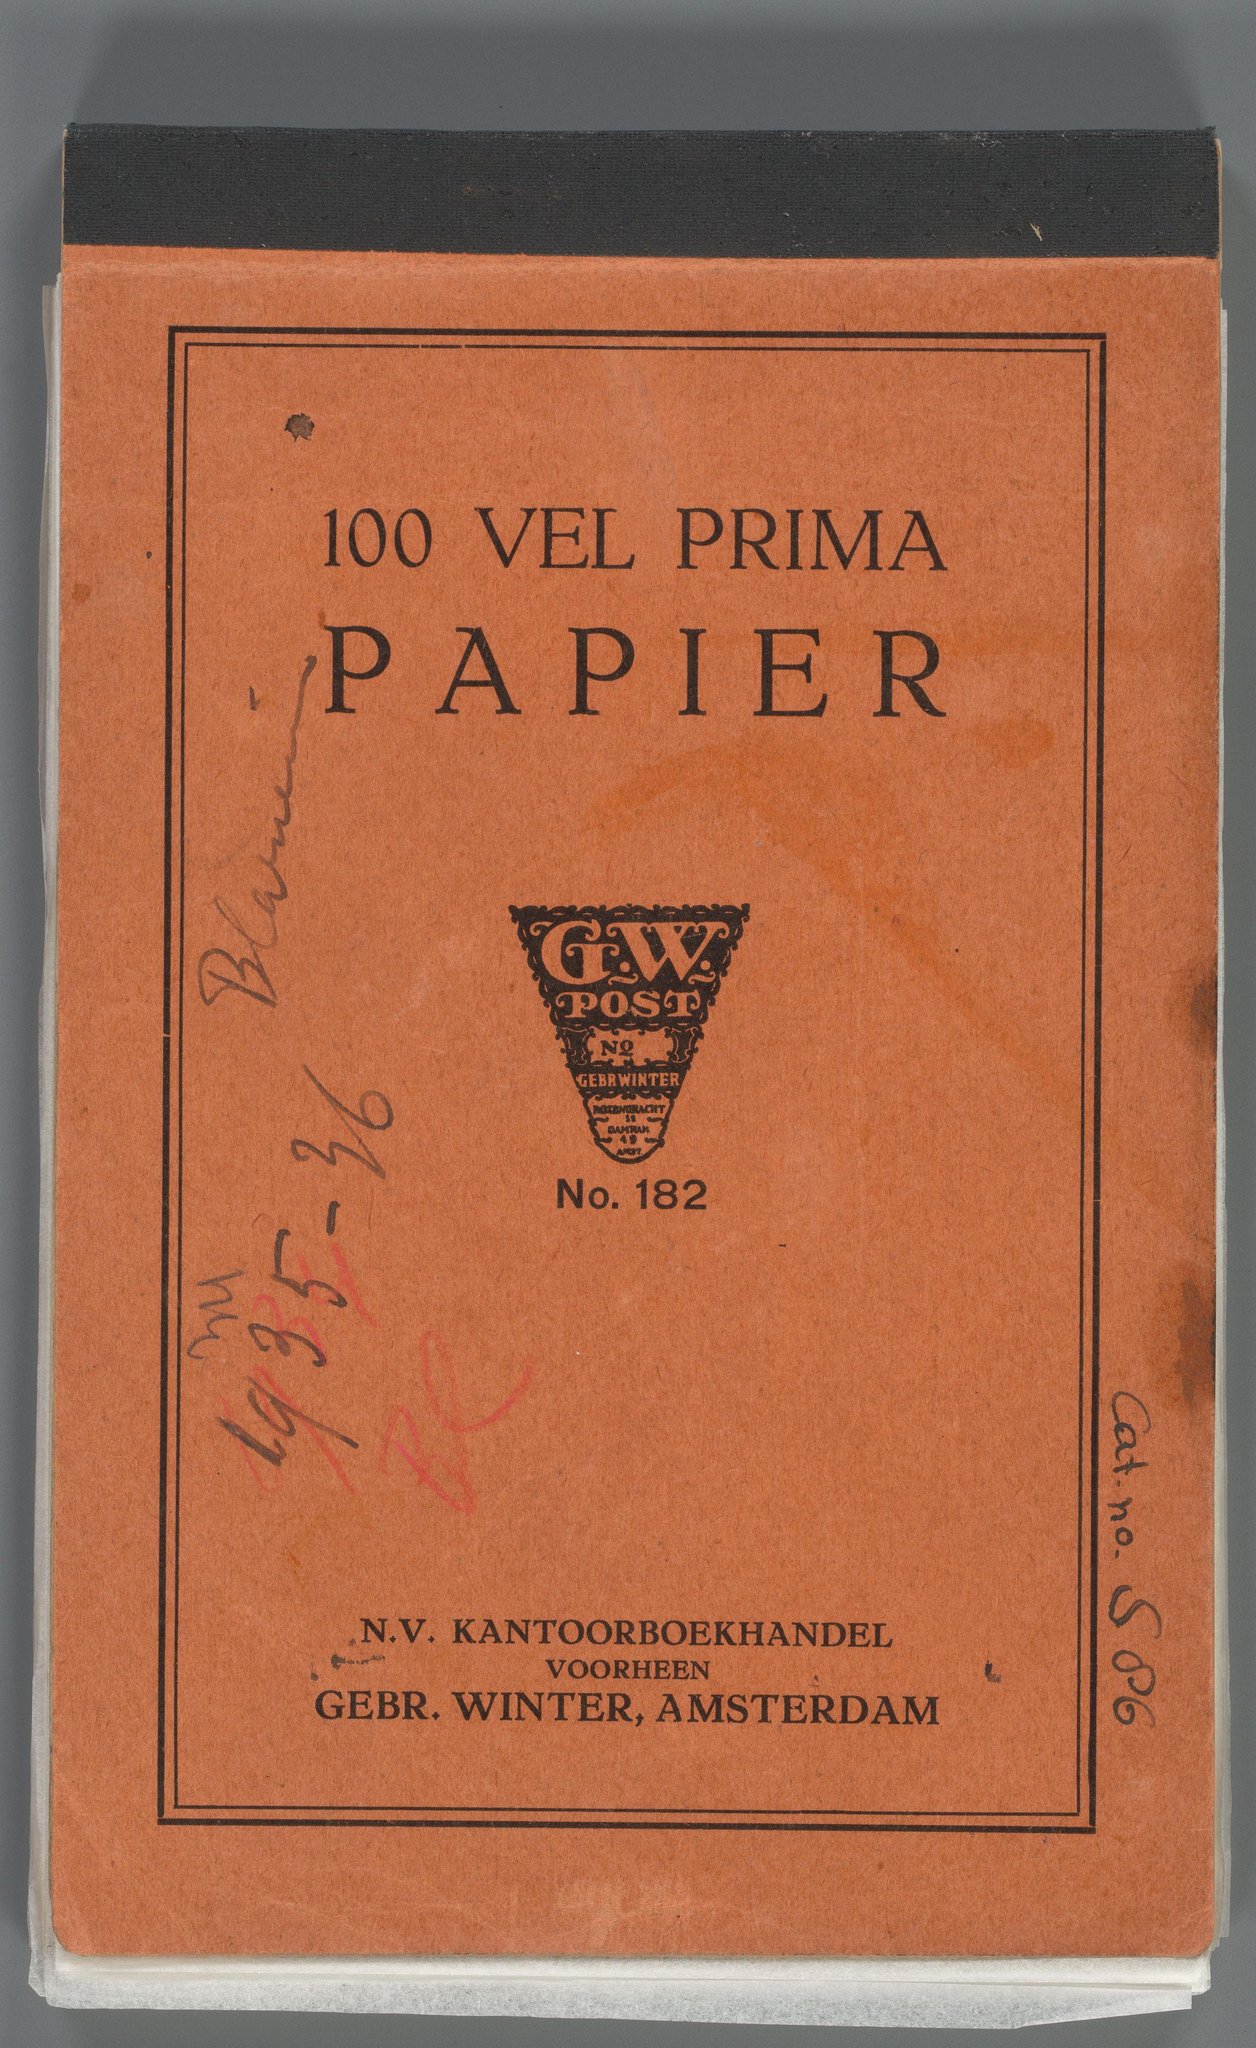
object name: sketchbook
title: Schetsboek Blaricum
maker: leo gestel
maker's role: draughtsman, print maker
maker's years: 1881-1941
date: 1935-1936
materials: chalk, ink, paper, pencil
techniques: drawing, pen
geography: blaricum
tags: cow, horse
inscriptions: inscription: ‘schetsboek 1935-1936/ [...]’, signature, date and inscription: ‘LG 35-36 Blaricum’, workshop stamp: Lugt 1078a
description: Schetsboek met tekeningen van: mannenkoppen, landschap, vee (in weiland) en paarden.